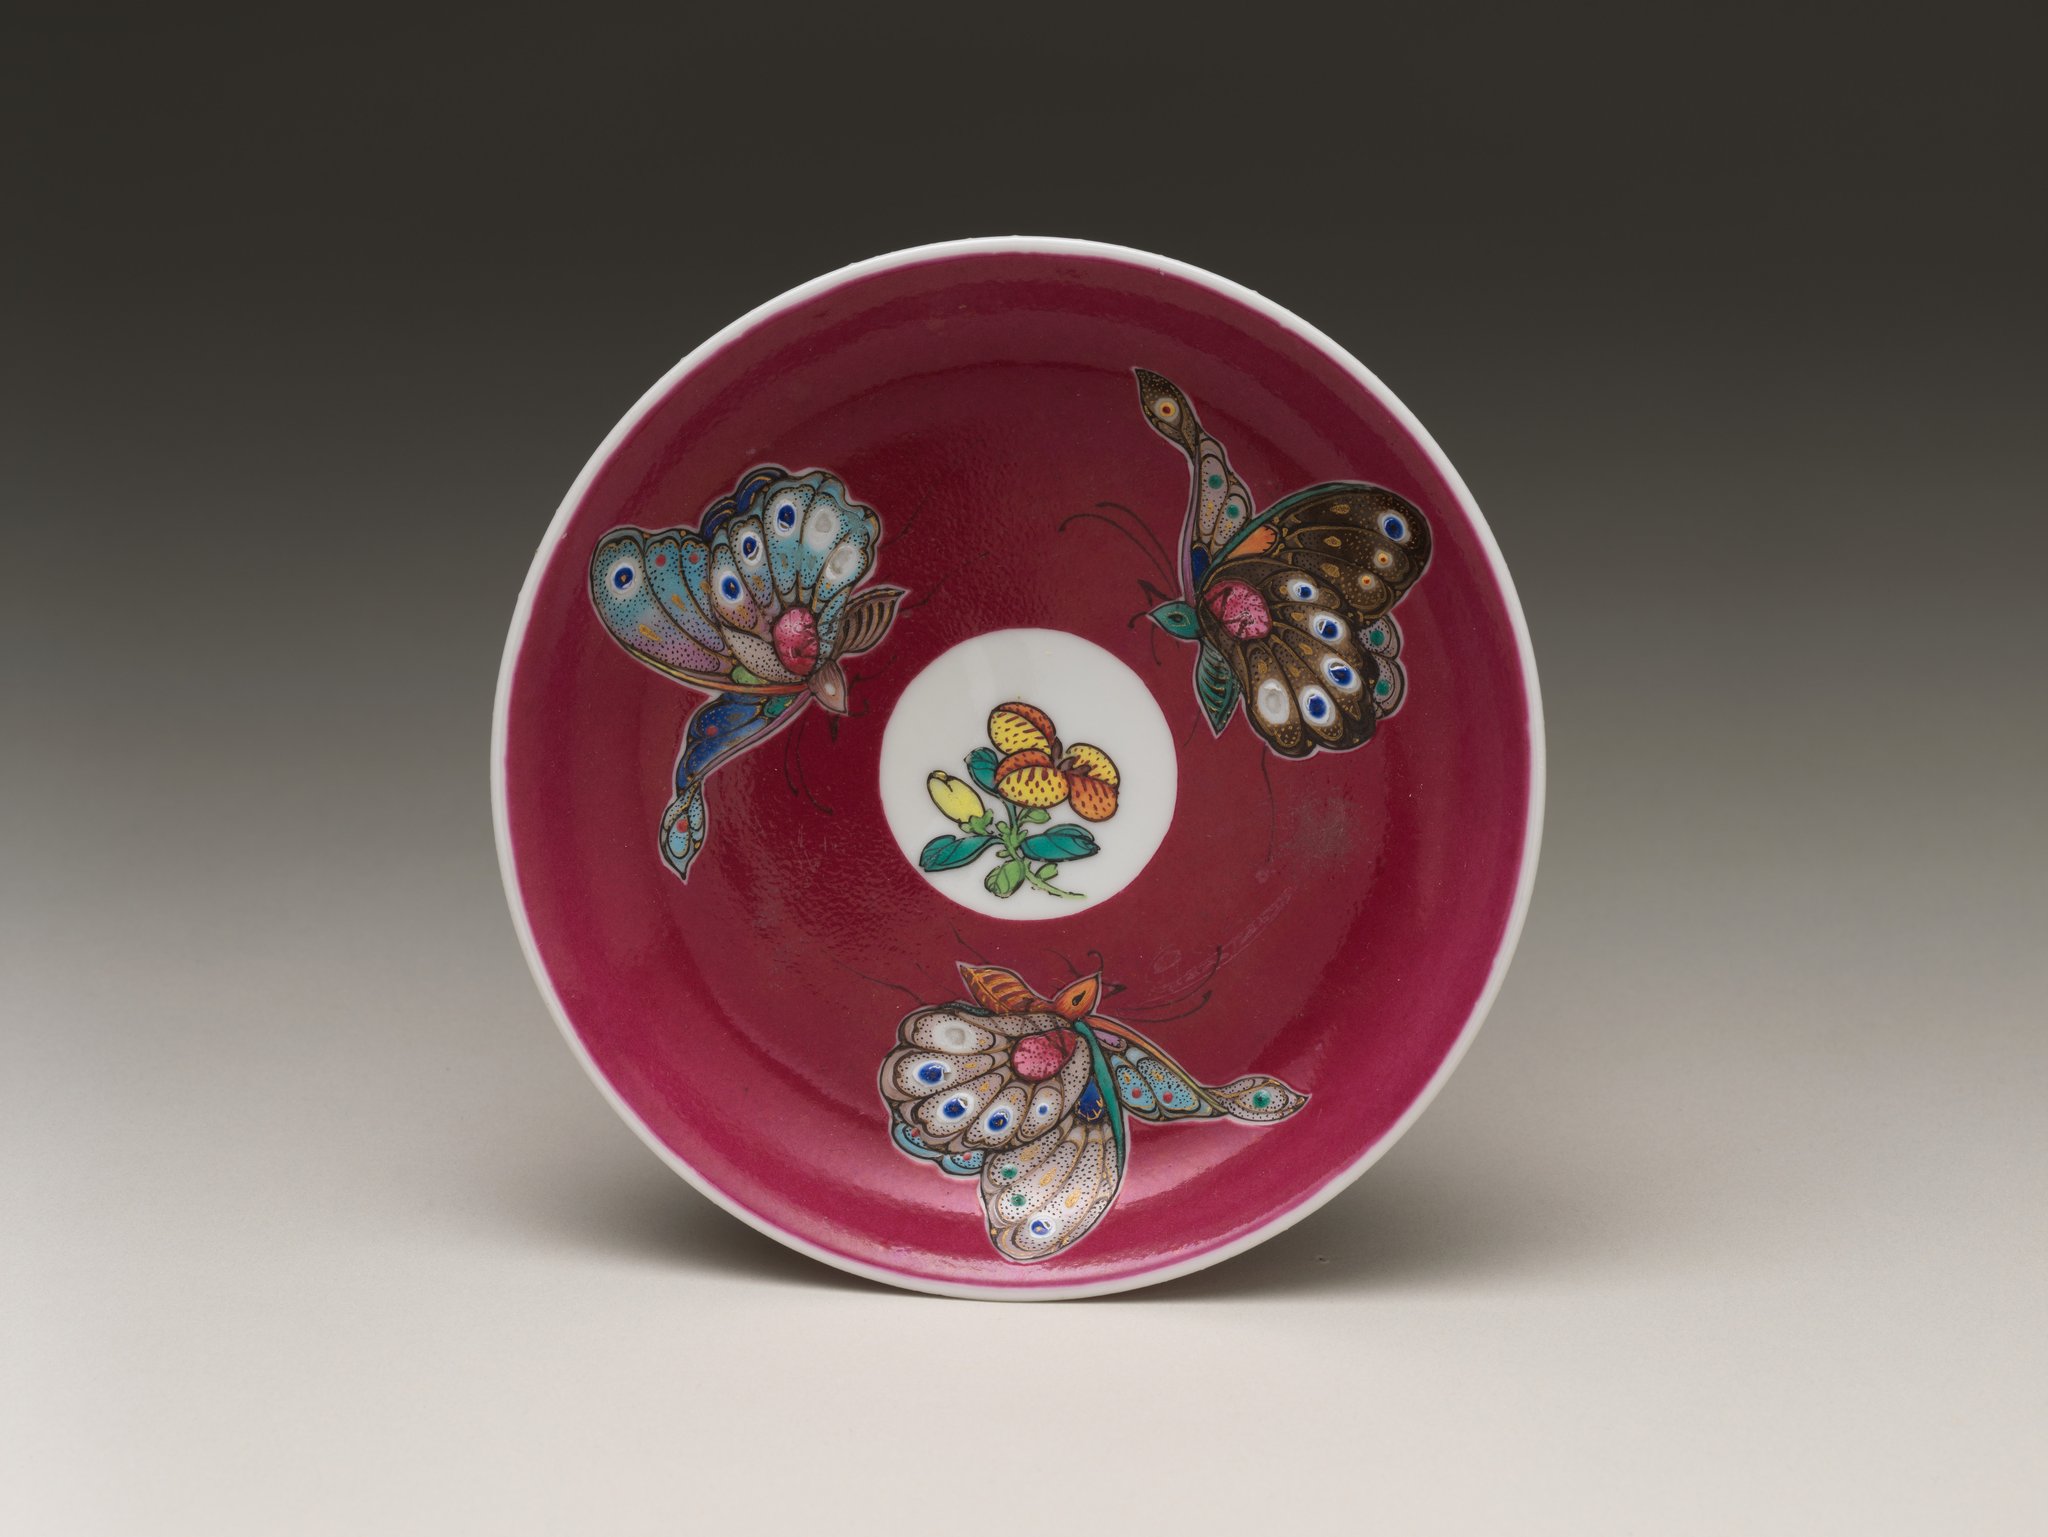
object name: saucer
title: Saucer with Butterflies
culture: chinese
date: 1701-1800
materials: enamel, porcelain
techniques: gilding, painting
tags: butterflies